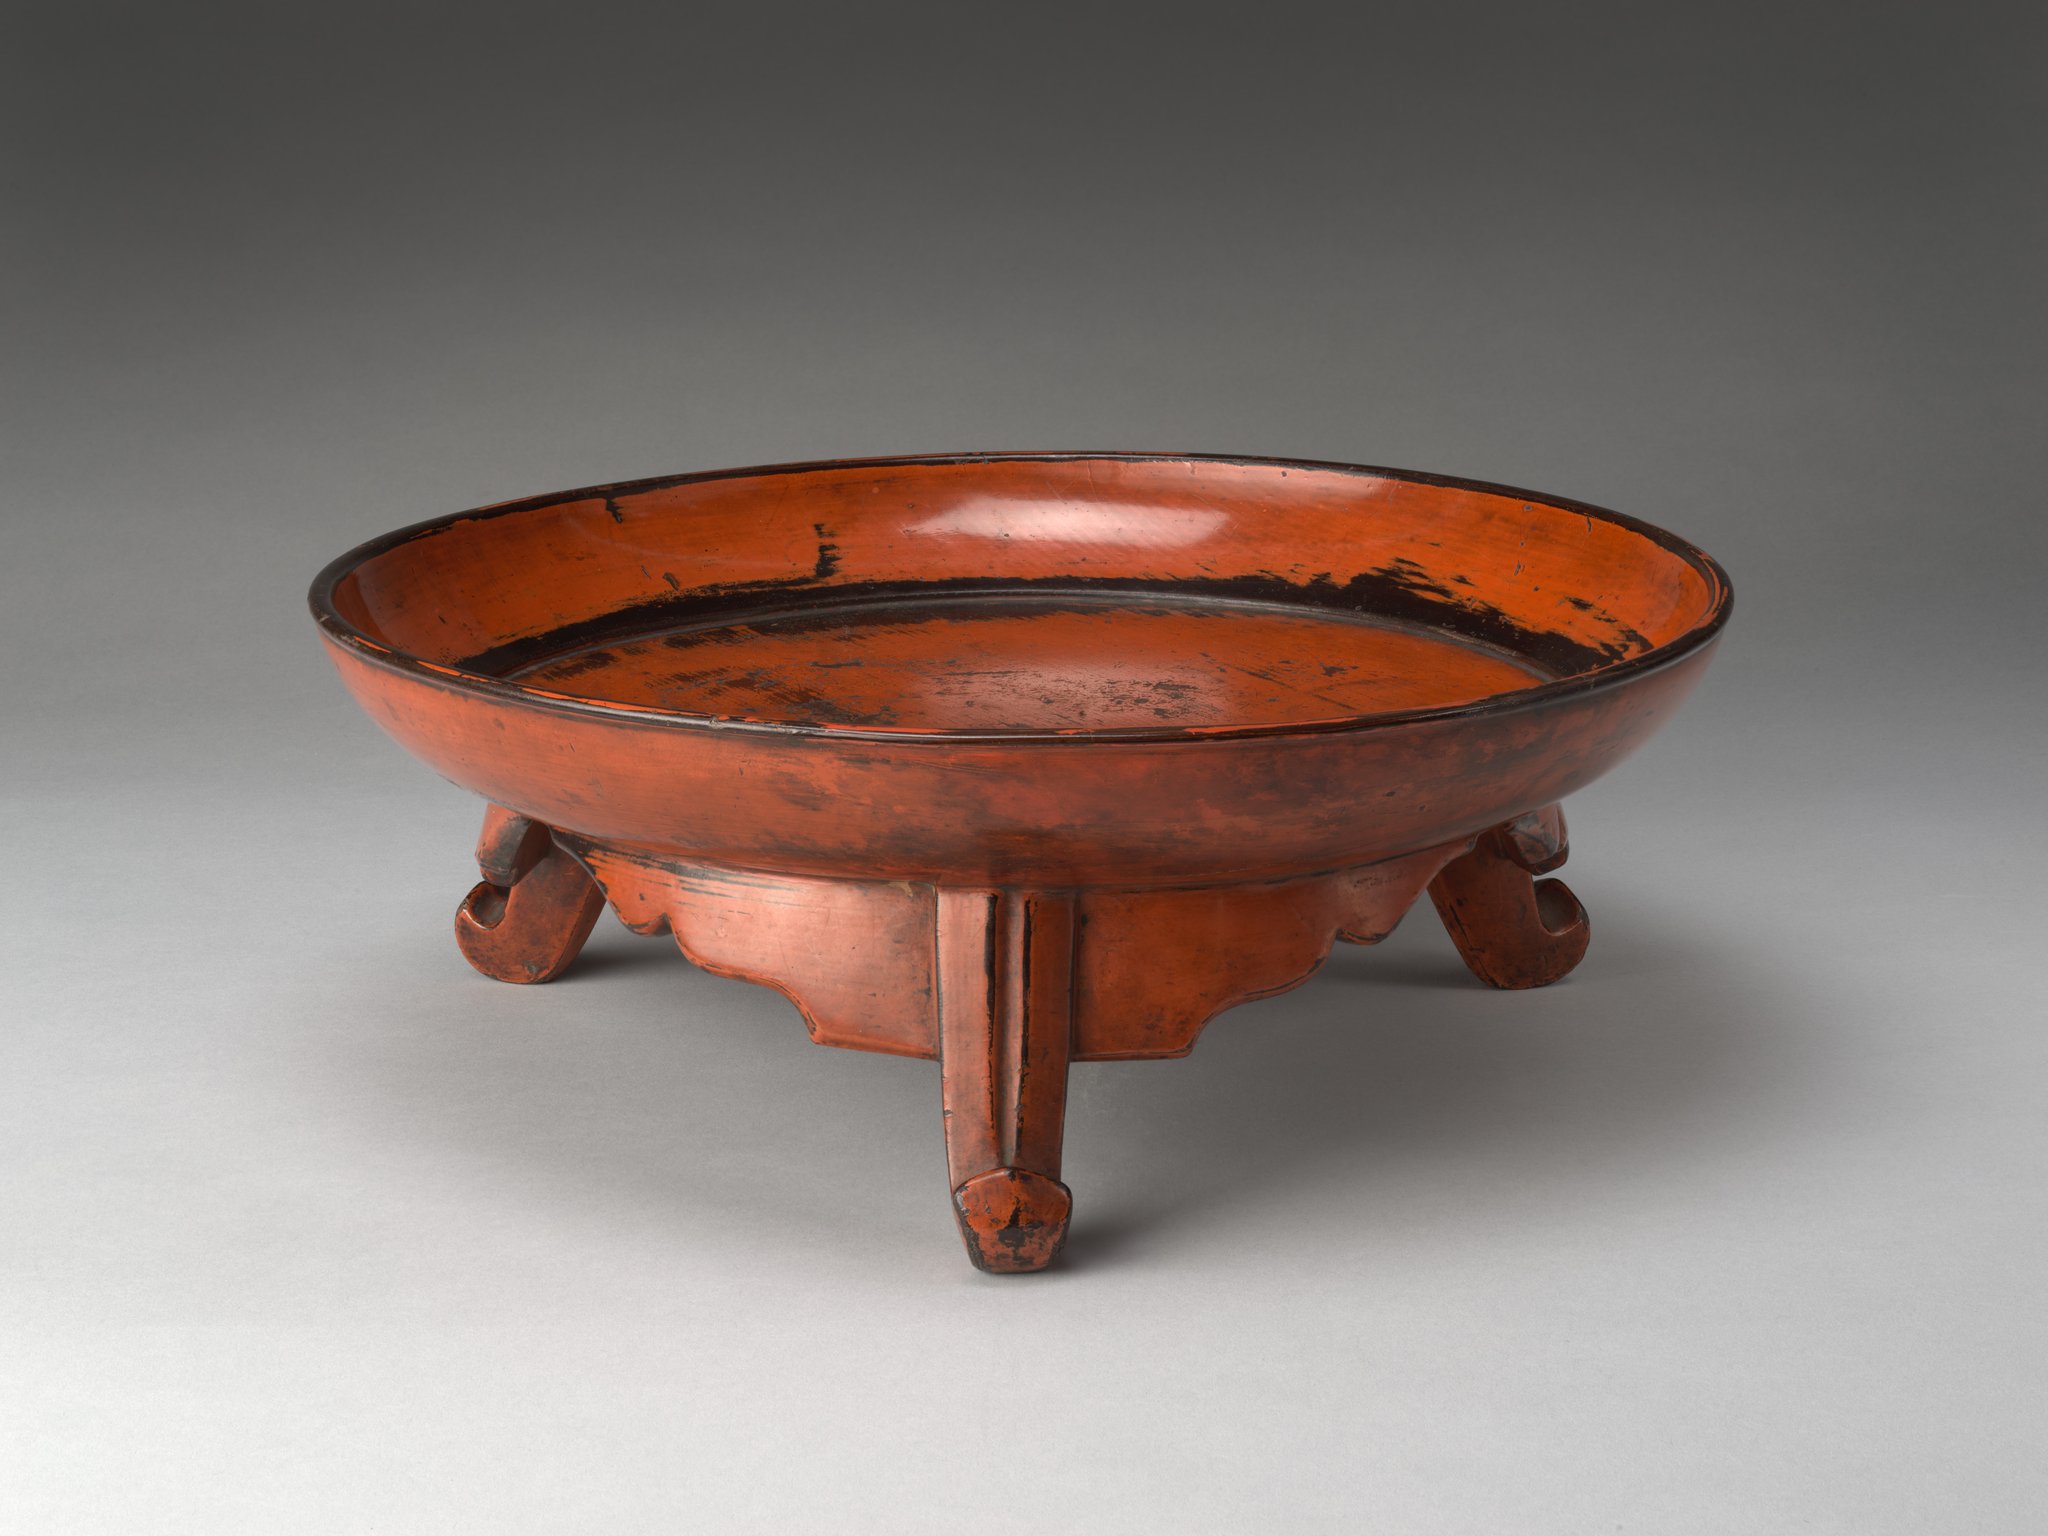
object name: tray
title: Round tray on three feet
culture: japanese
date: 1401-1600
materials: lacquer